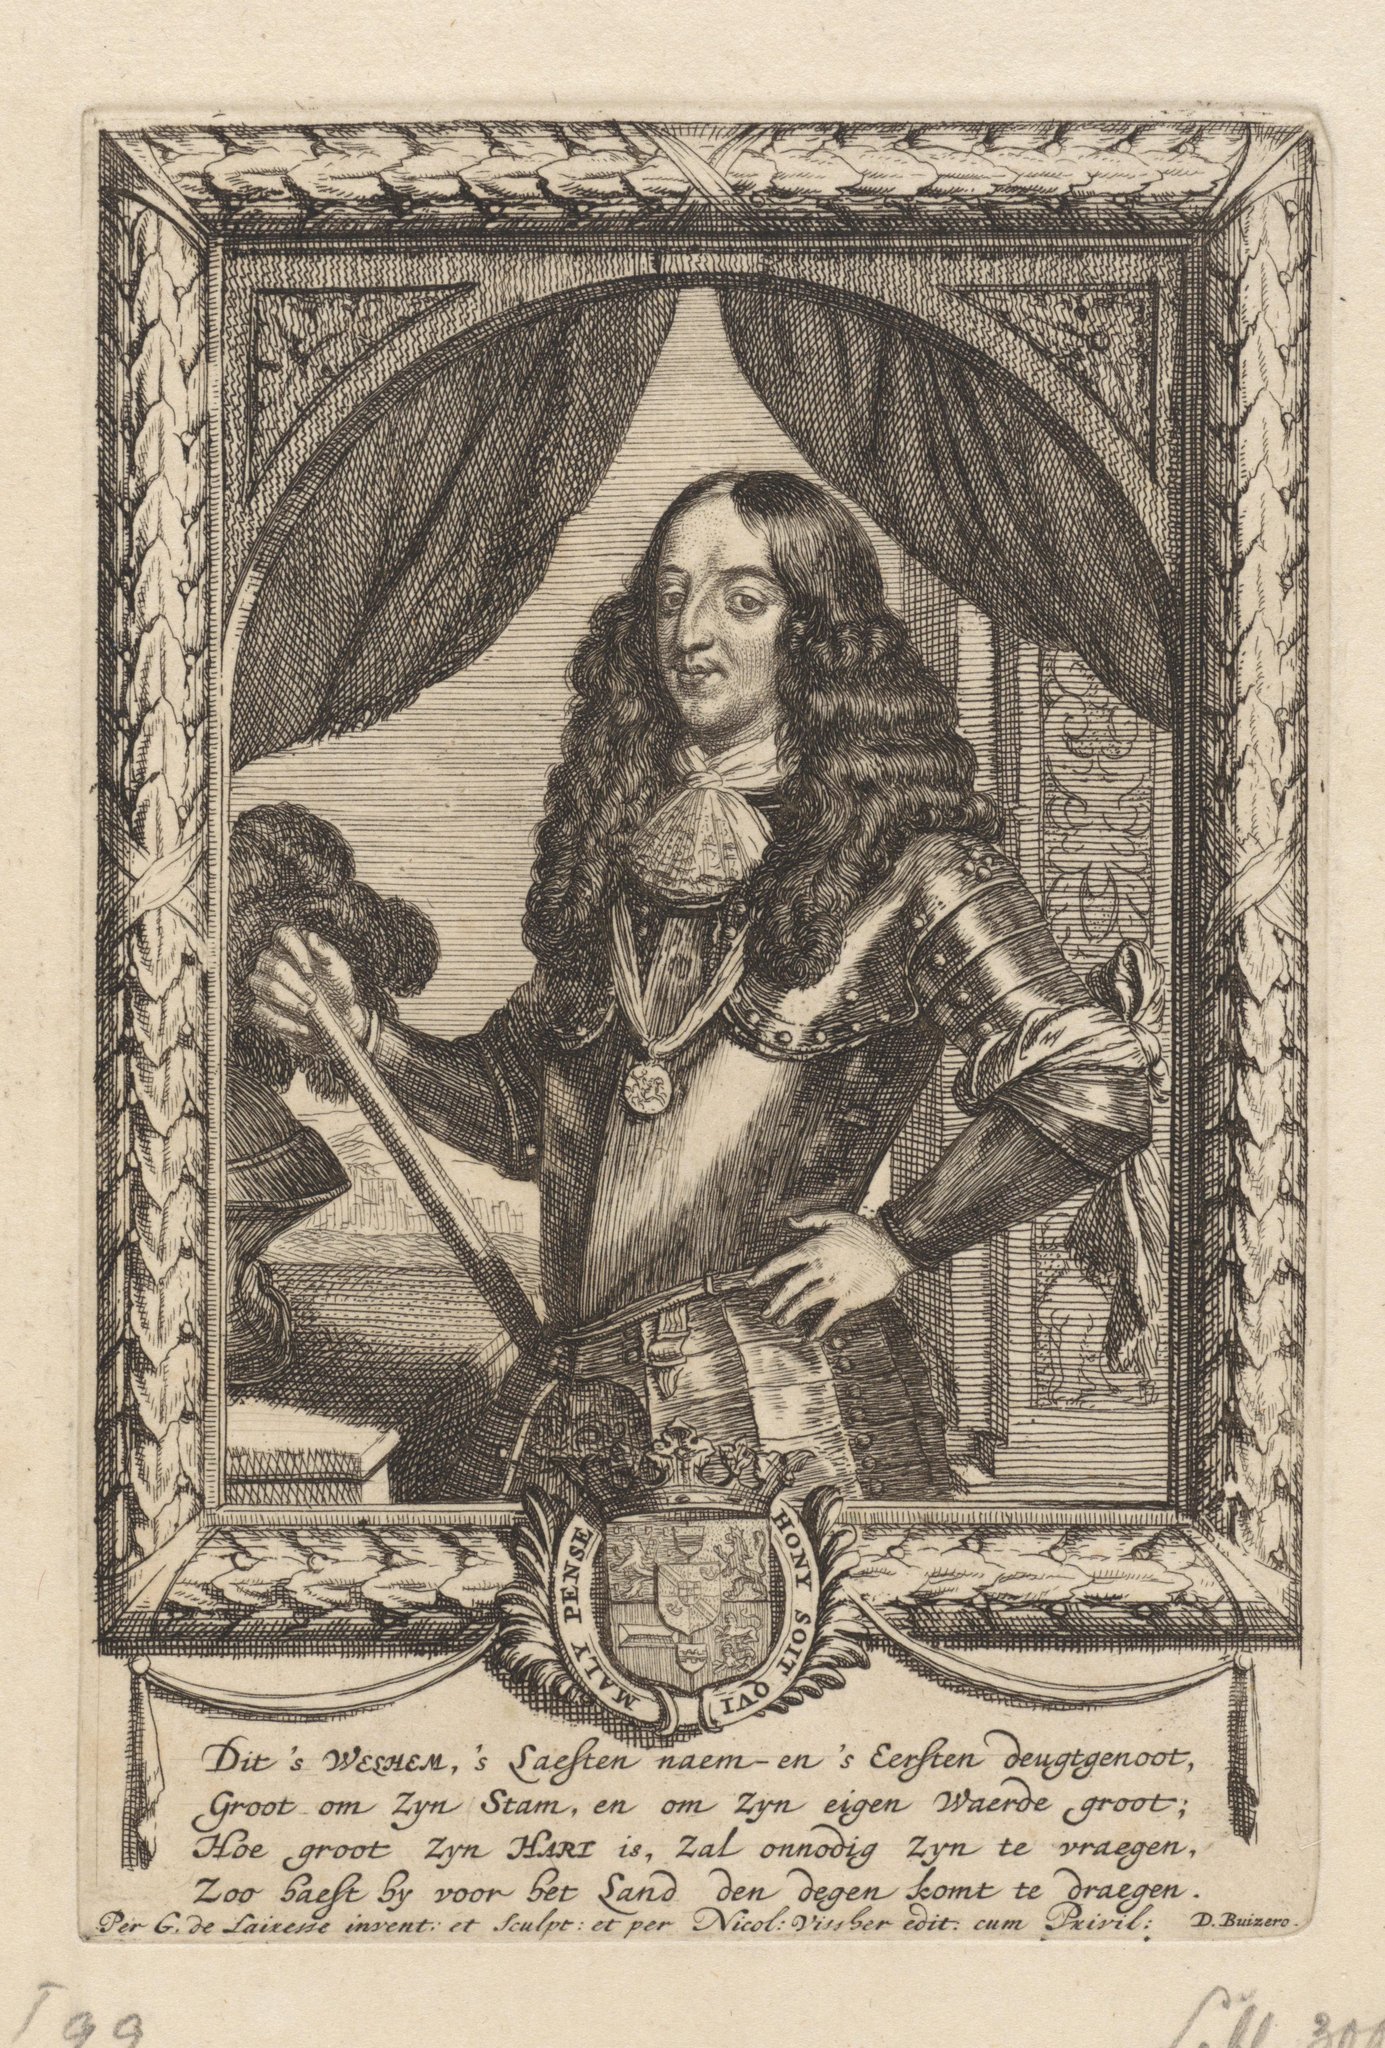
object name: print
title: Portret van prins Willem III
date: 1670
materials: paper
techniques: etching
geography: amsterdam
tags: the hague, william iii (prince of orange and king of england, scotland, and ireland)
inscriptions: collector's mark: Lugt 2228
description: Portret van Willem III, prins van Oranje-Nassau en koning van Engeland, gehuld in een harnas en blootshoofds. Heupstuk, staand naar links gedraaid, met scepter. De lijst rond het portret is onderaan versierd met het wapen van Willem III, in de marge een vierregelig vers in het Nederlands. Prent op onversneden blad met 4 afbeeldingen.